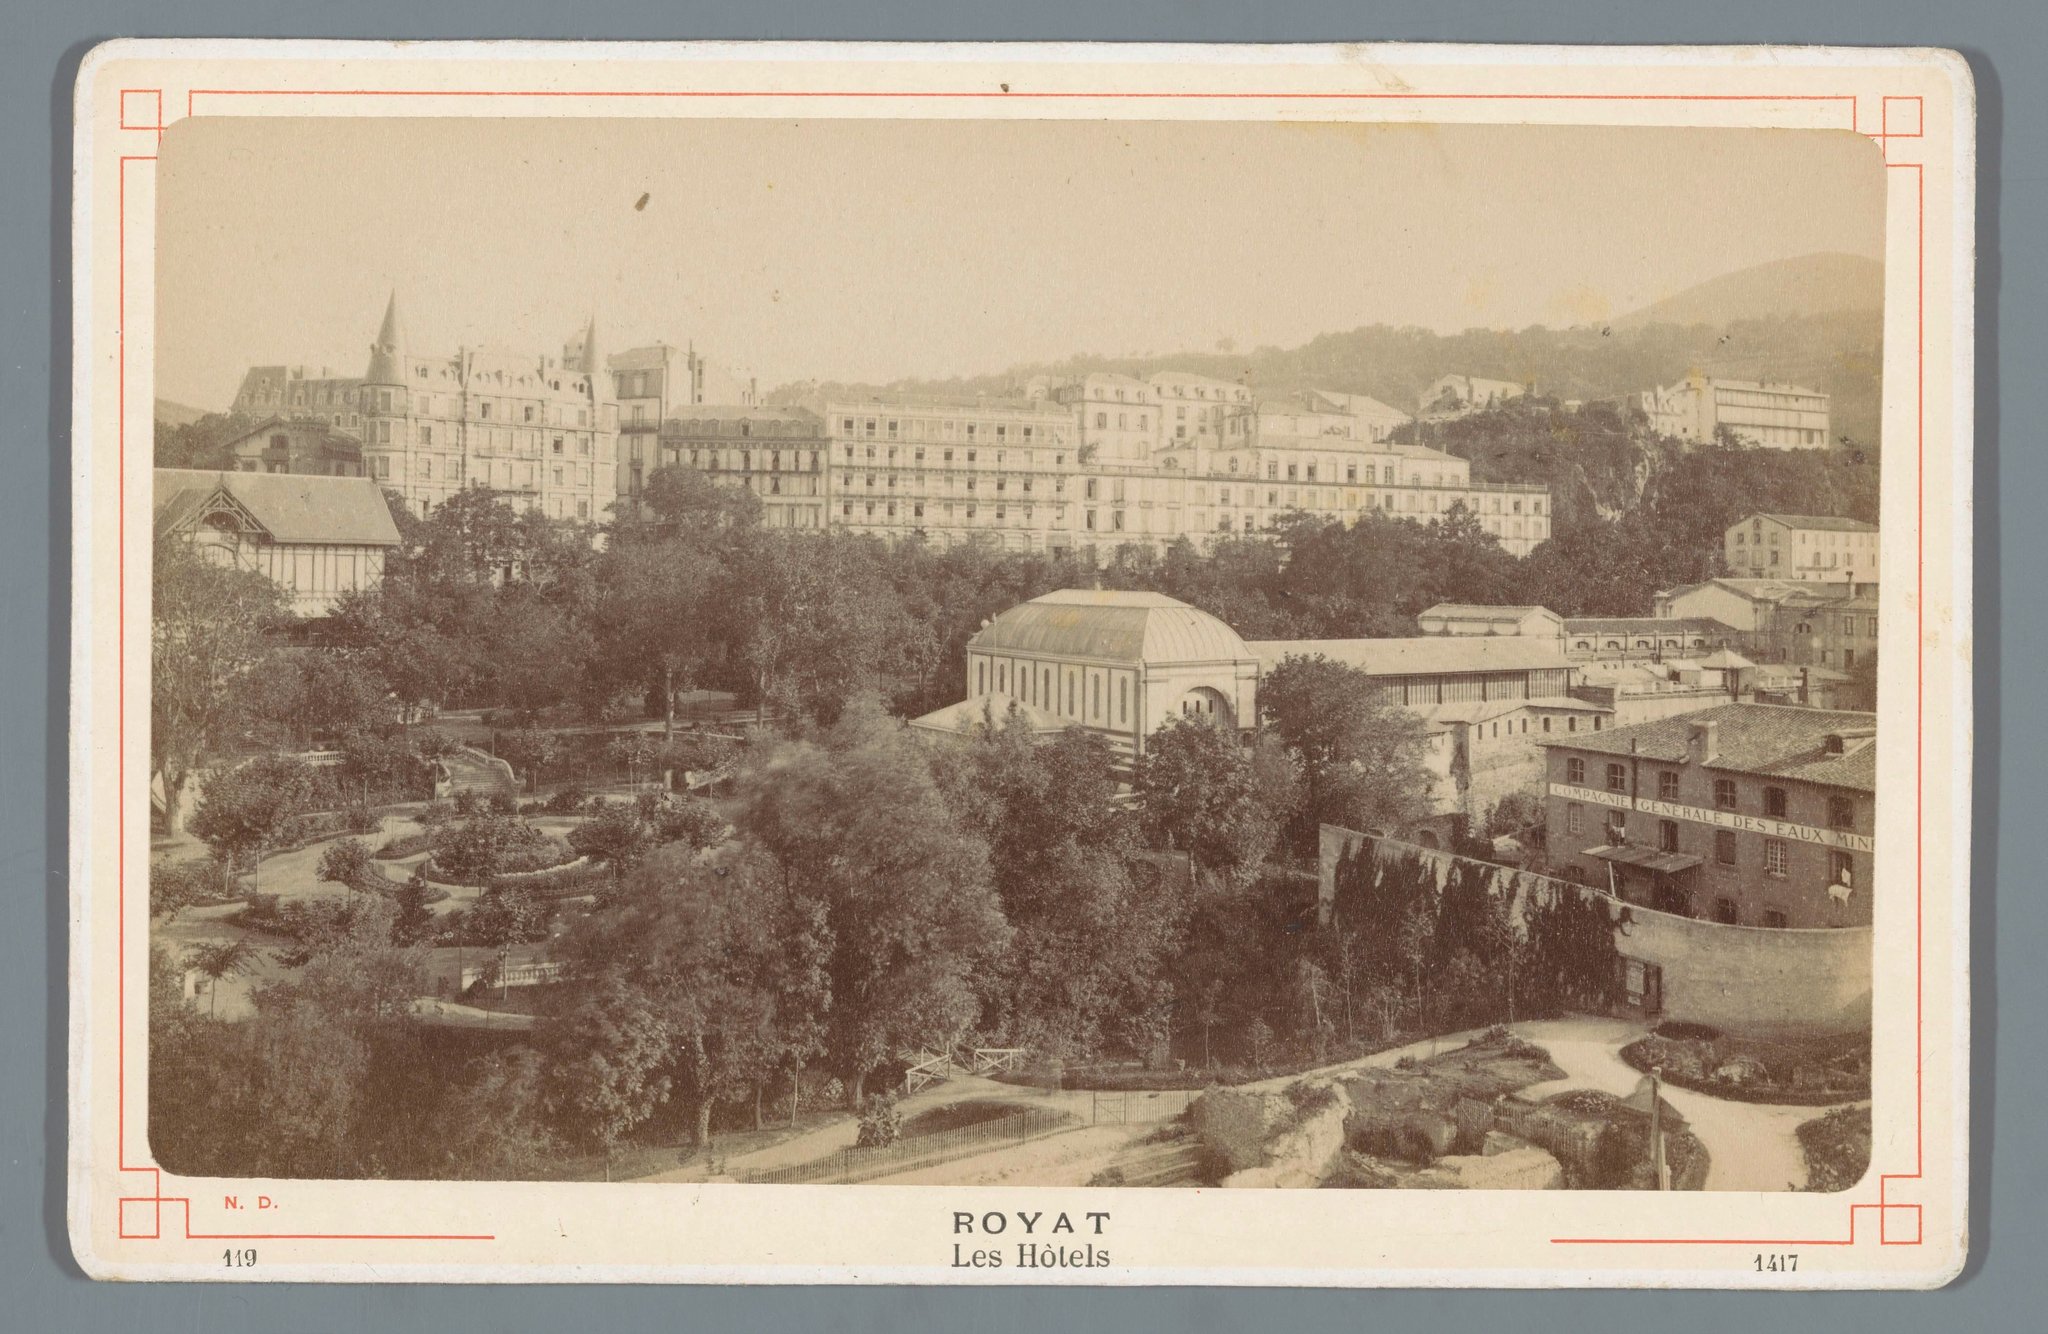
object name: cabinet photograph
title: Royat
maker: étienne neurdein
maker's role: publisher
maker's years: 1832-1918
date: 1870-1900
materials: cardboard, photographic support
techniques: albumen print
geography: royat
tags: city-view in general; 'veduta', hotel, hostelry, inn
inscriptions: number: ‘119/ 1417’, initials: ‘N.D.’